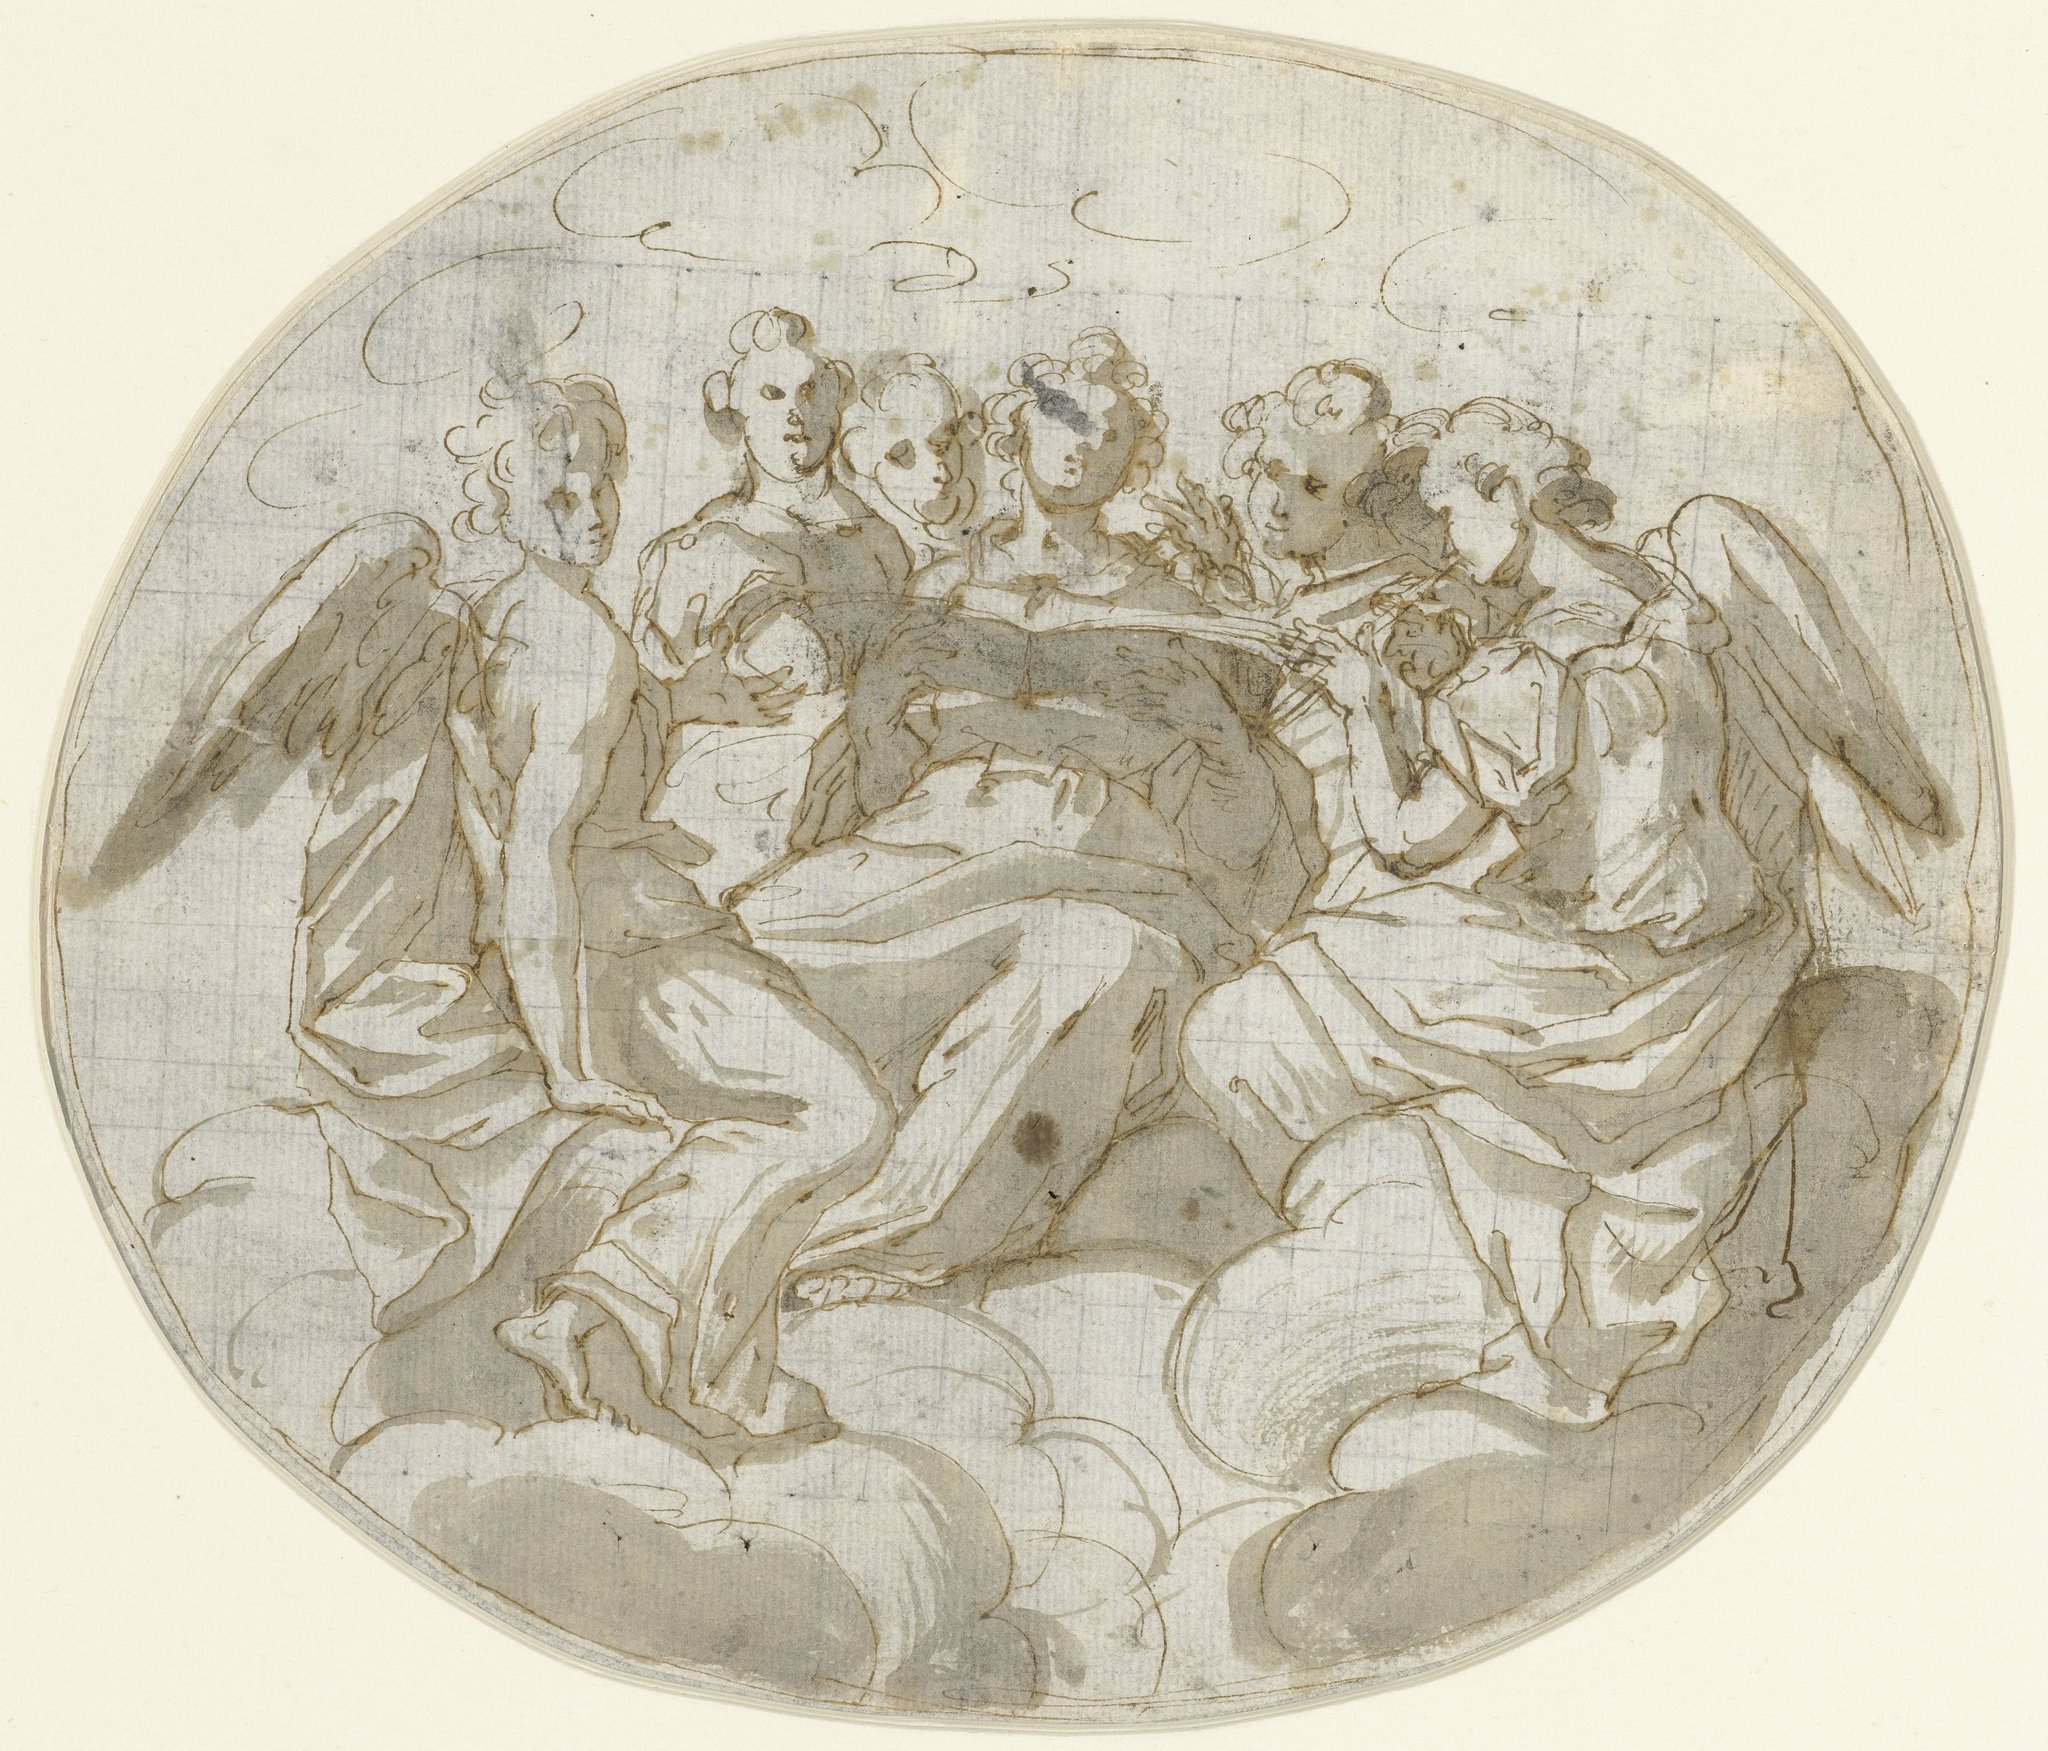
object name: drawing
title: Zingende engelen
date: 1600-1699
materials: chalk, graphite, ink, paper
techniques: brush, pen, drawing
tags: choir, angel(s) with book(-scroll) or banderole